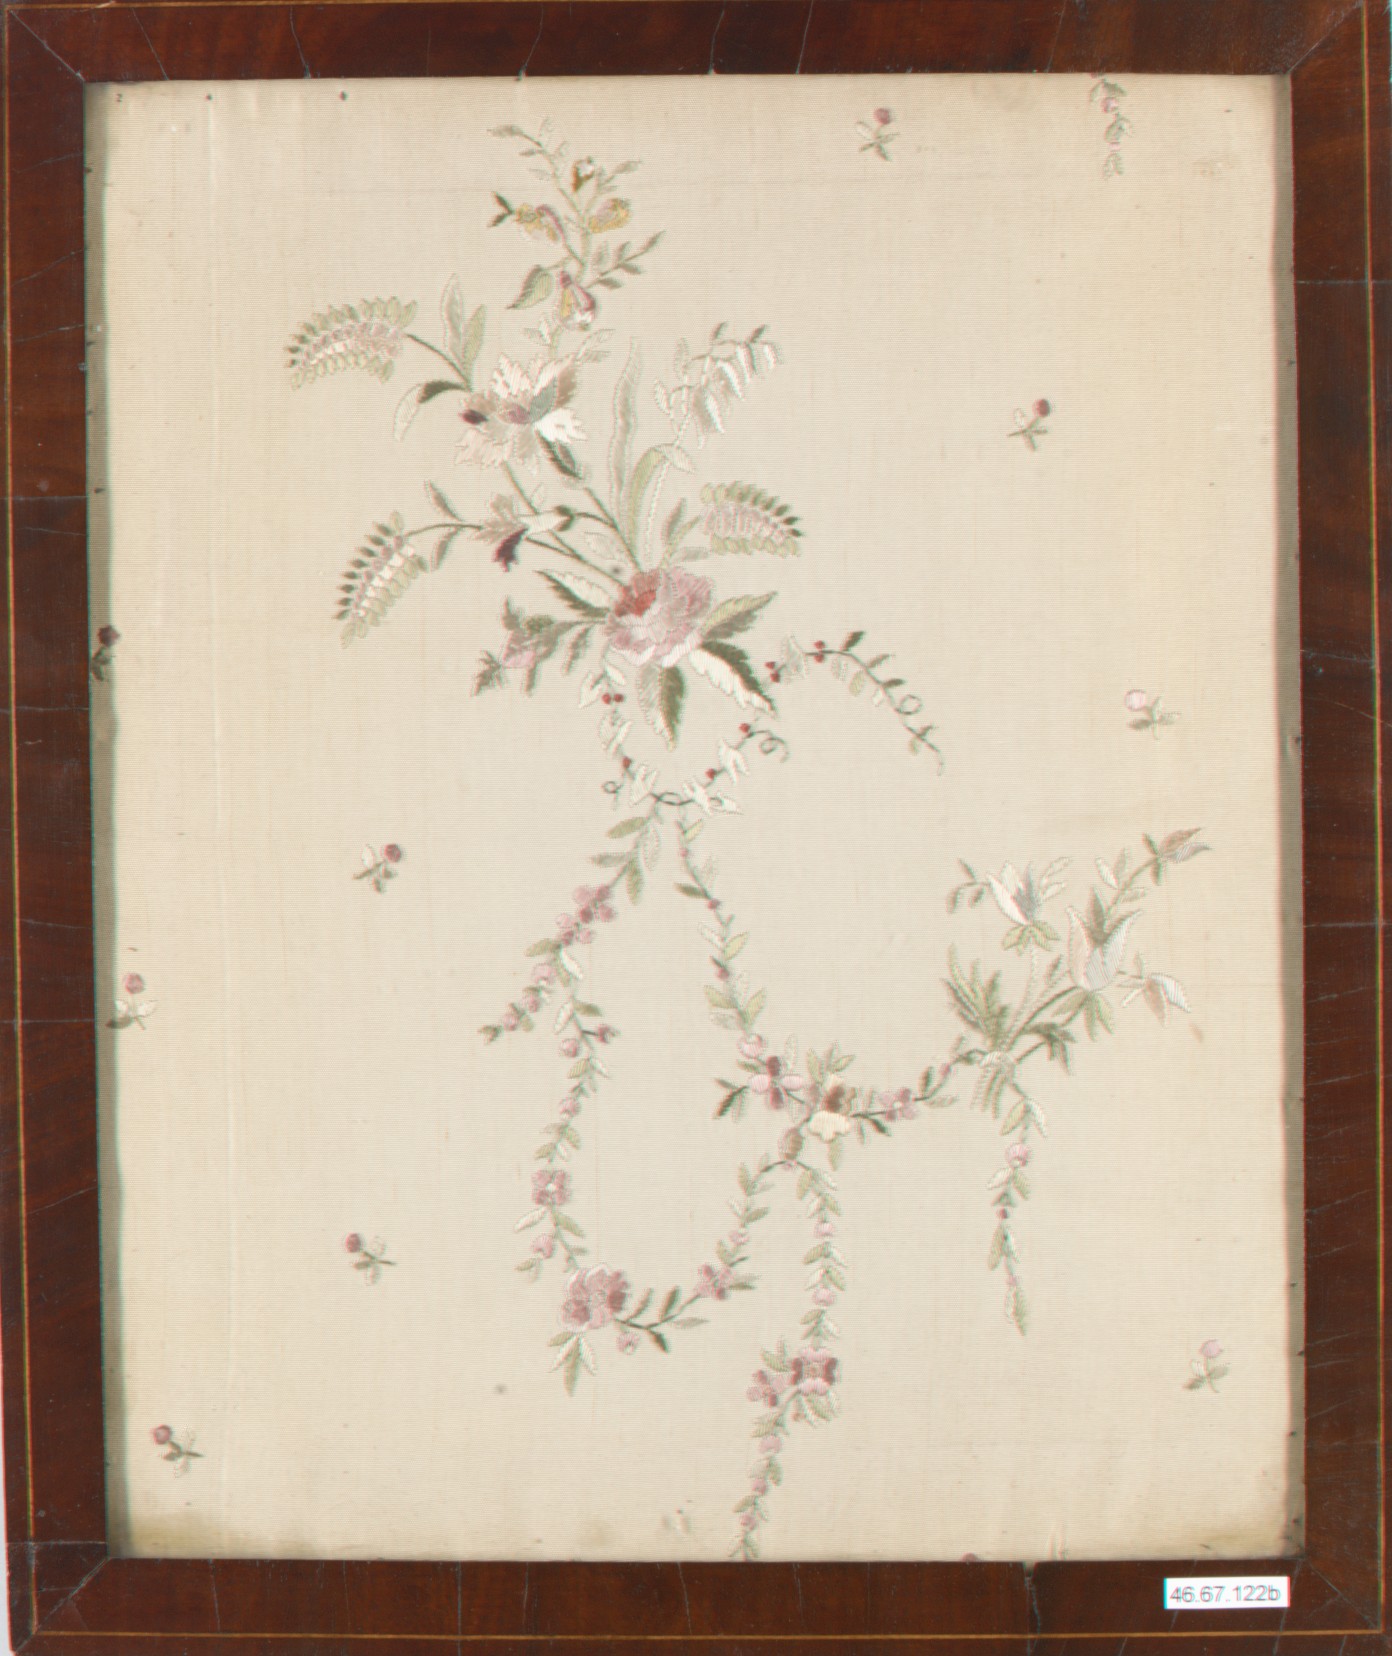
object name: firescreen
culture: american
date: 1780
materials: wood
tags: flowers